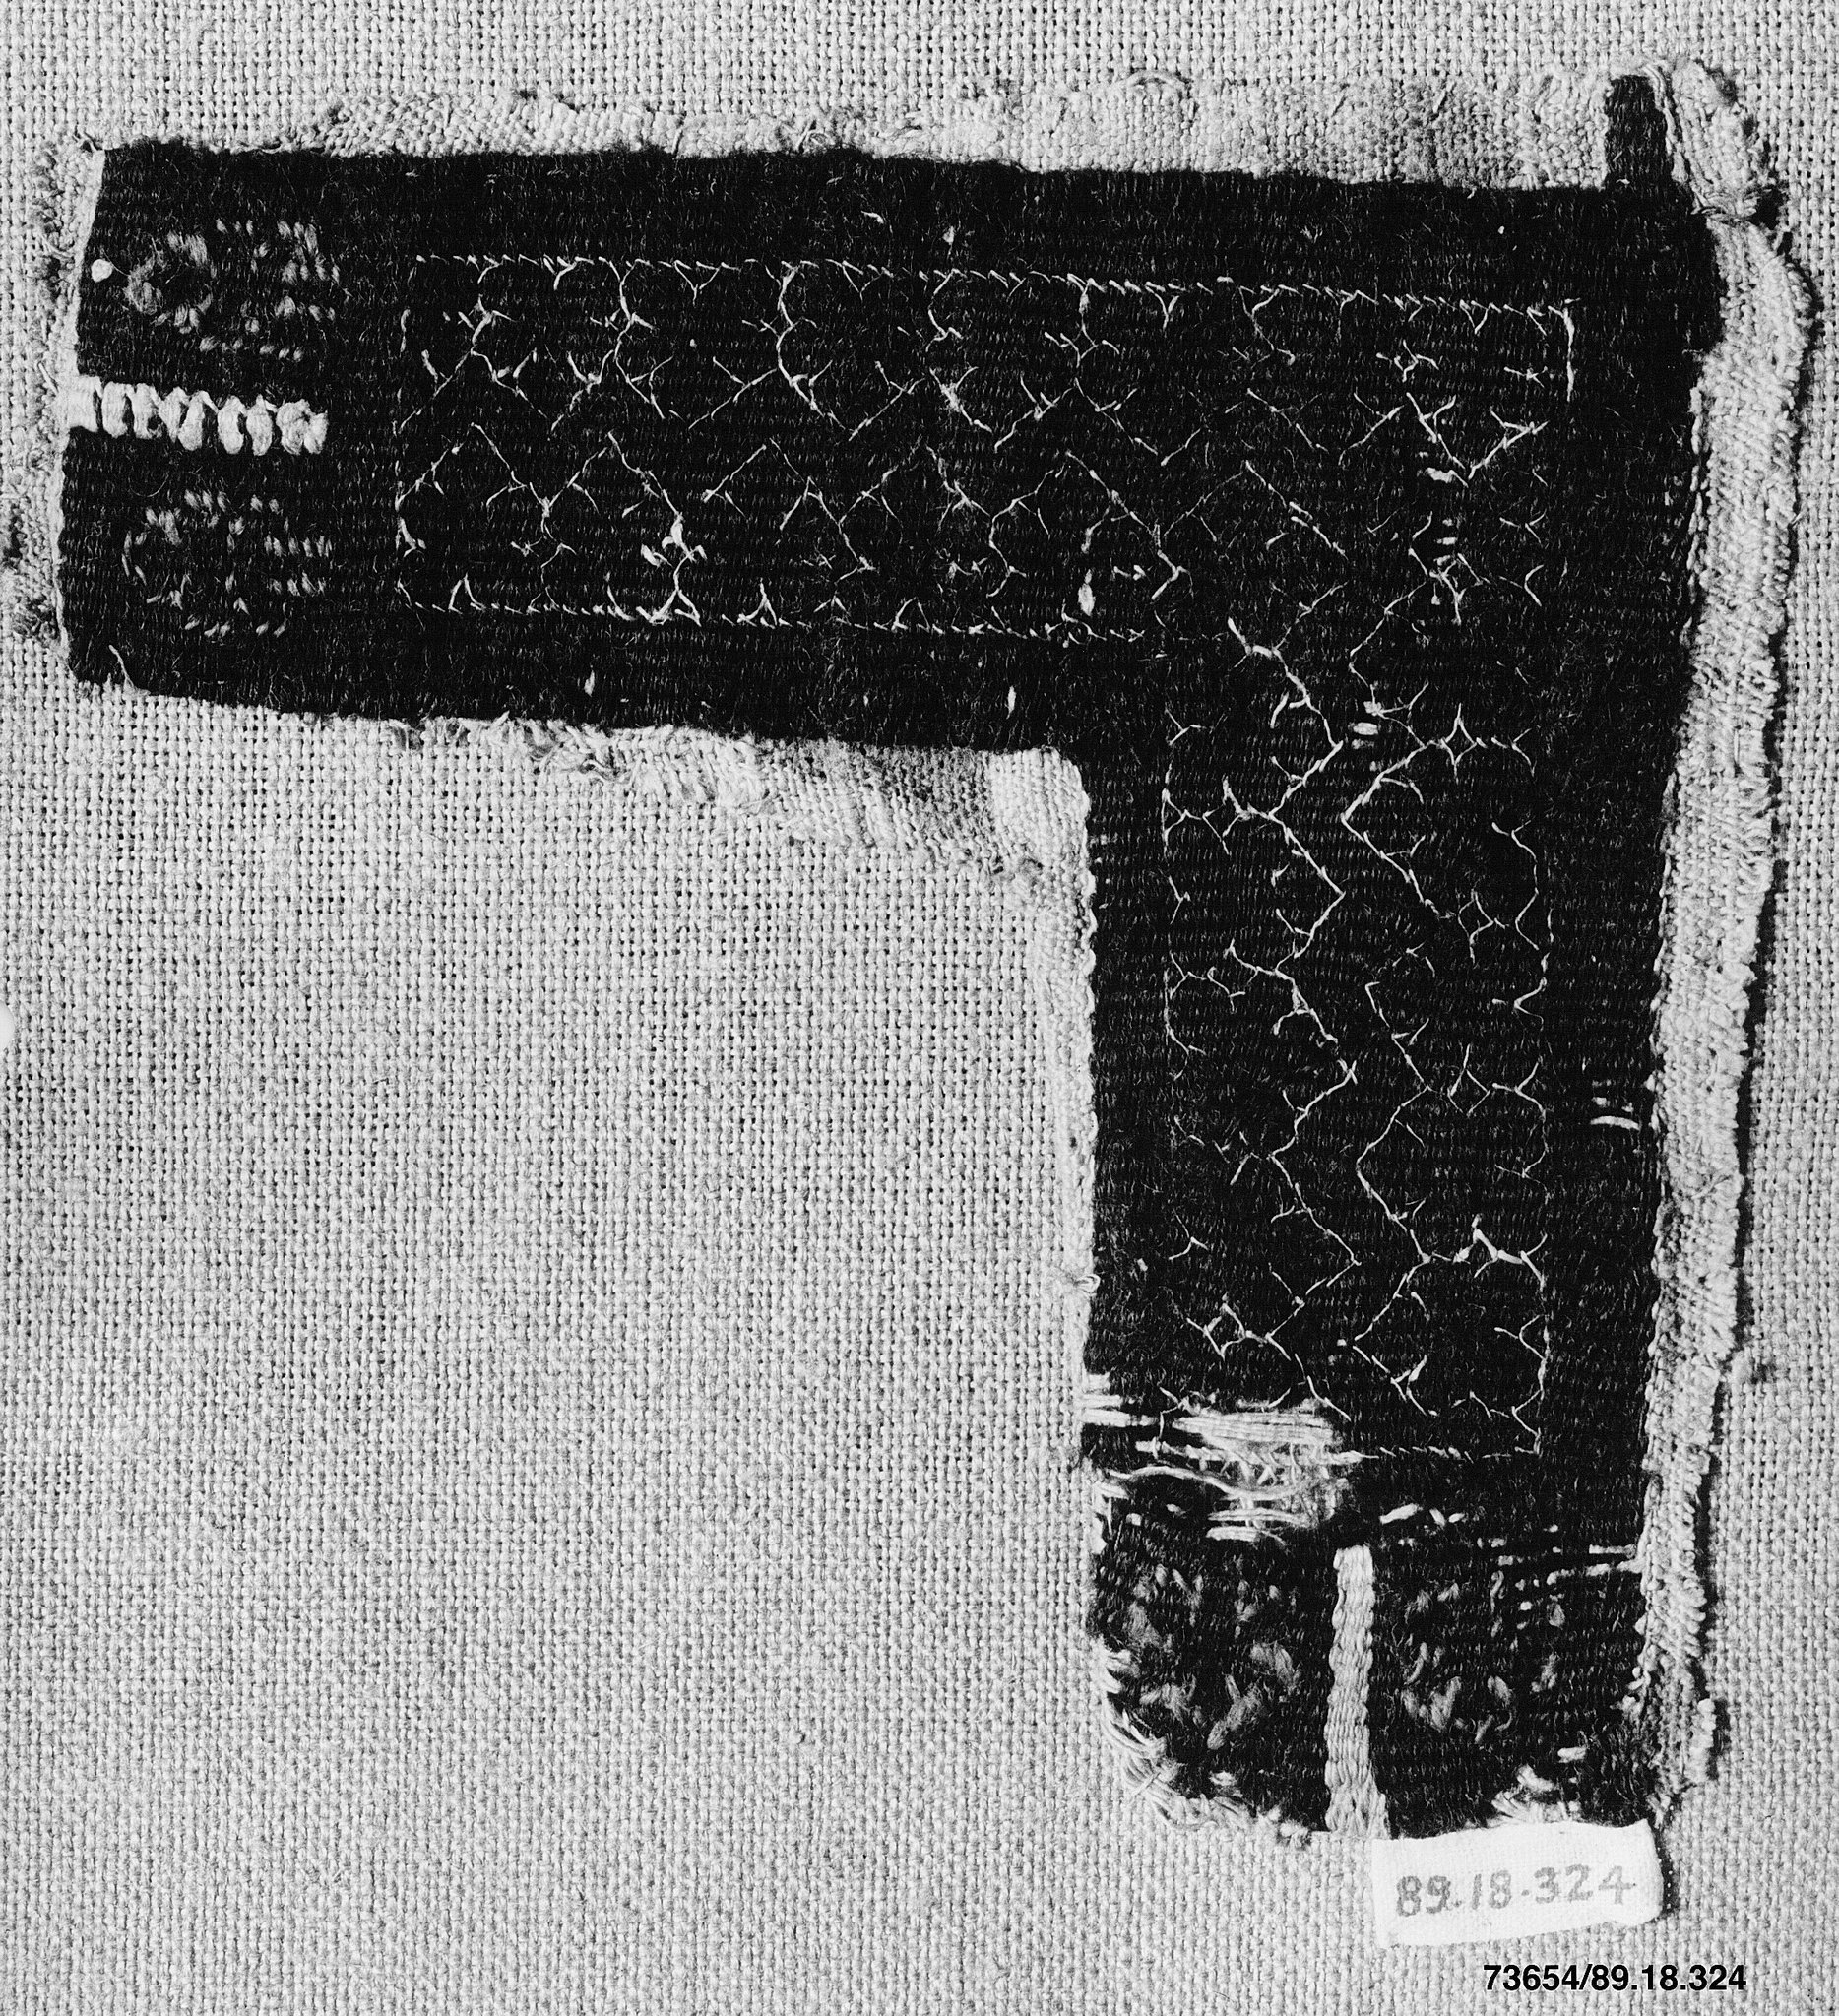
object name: textile fragment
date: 201-400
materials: linen, wool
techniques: weave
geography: egypt